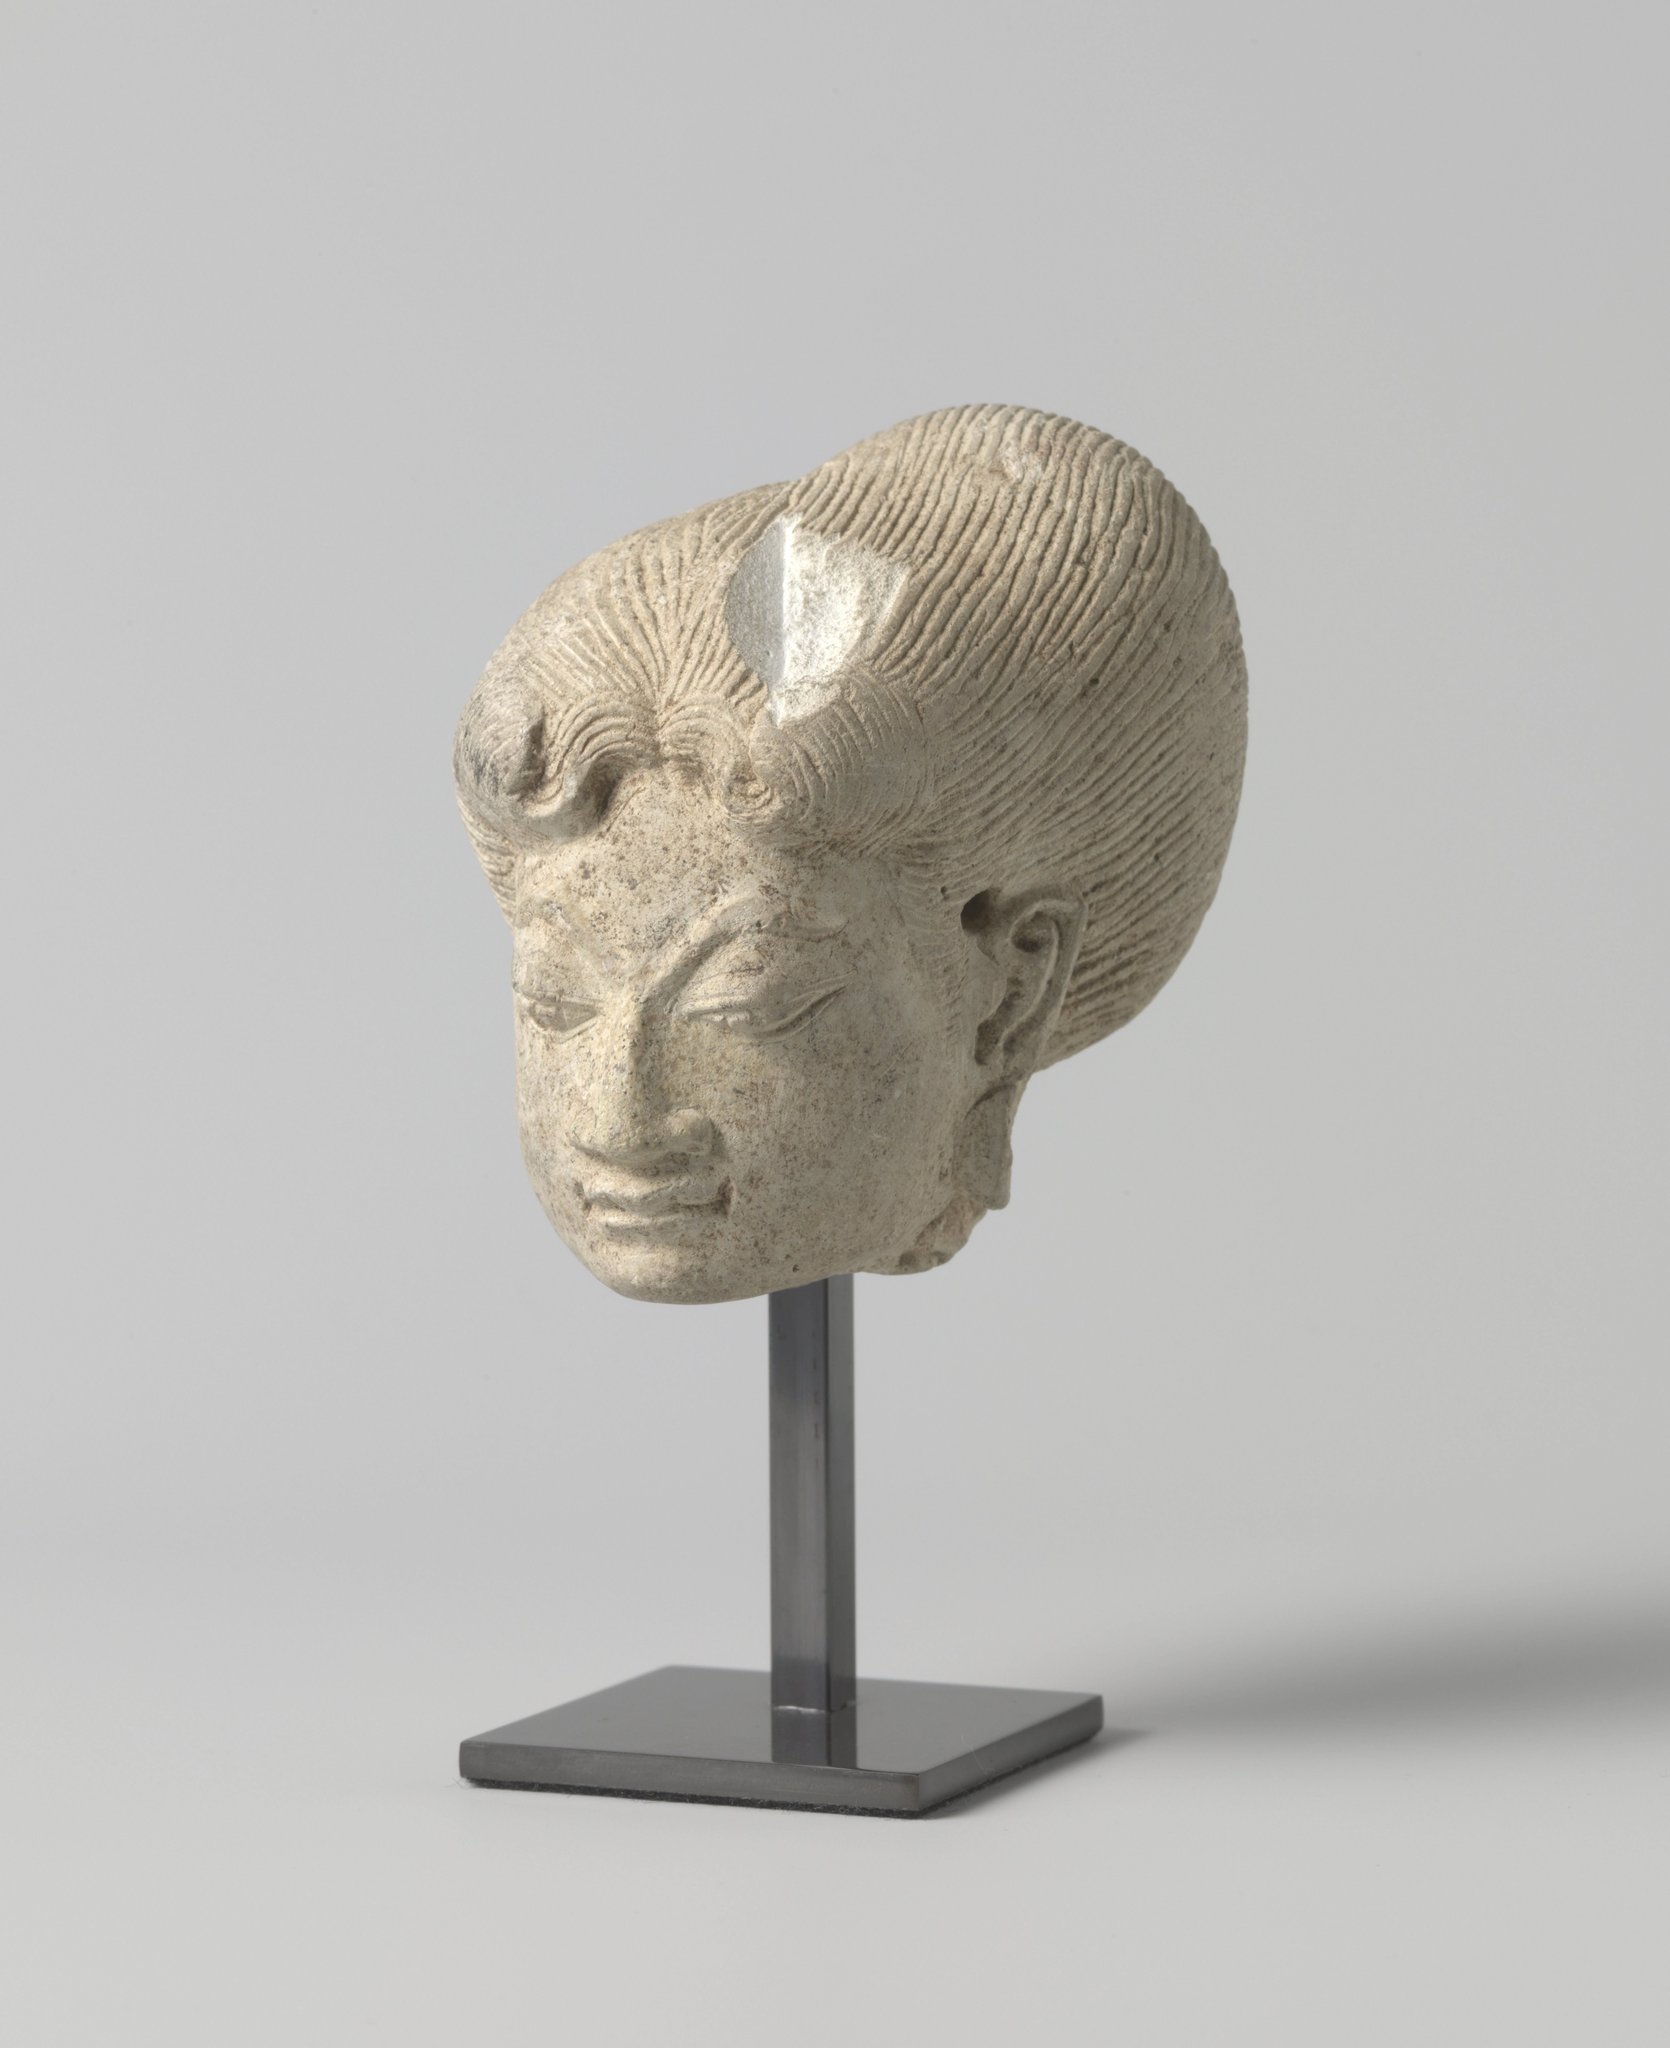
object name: sculpture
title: Hoofd van een hemelnimf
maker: Anonymous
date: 1300-1500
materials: metal, stone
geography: indonesia